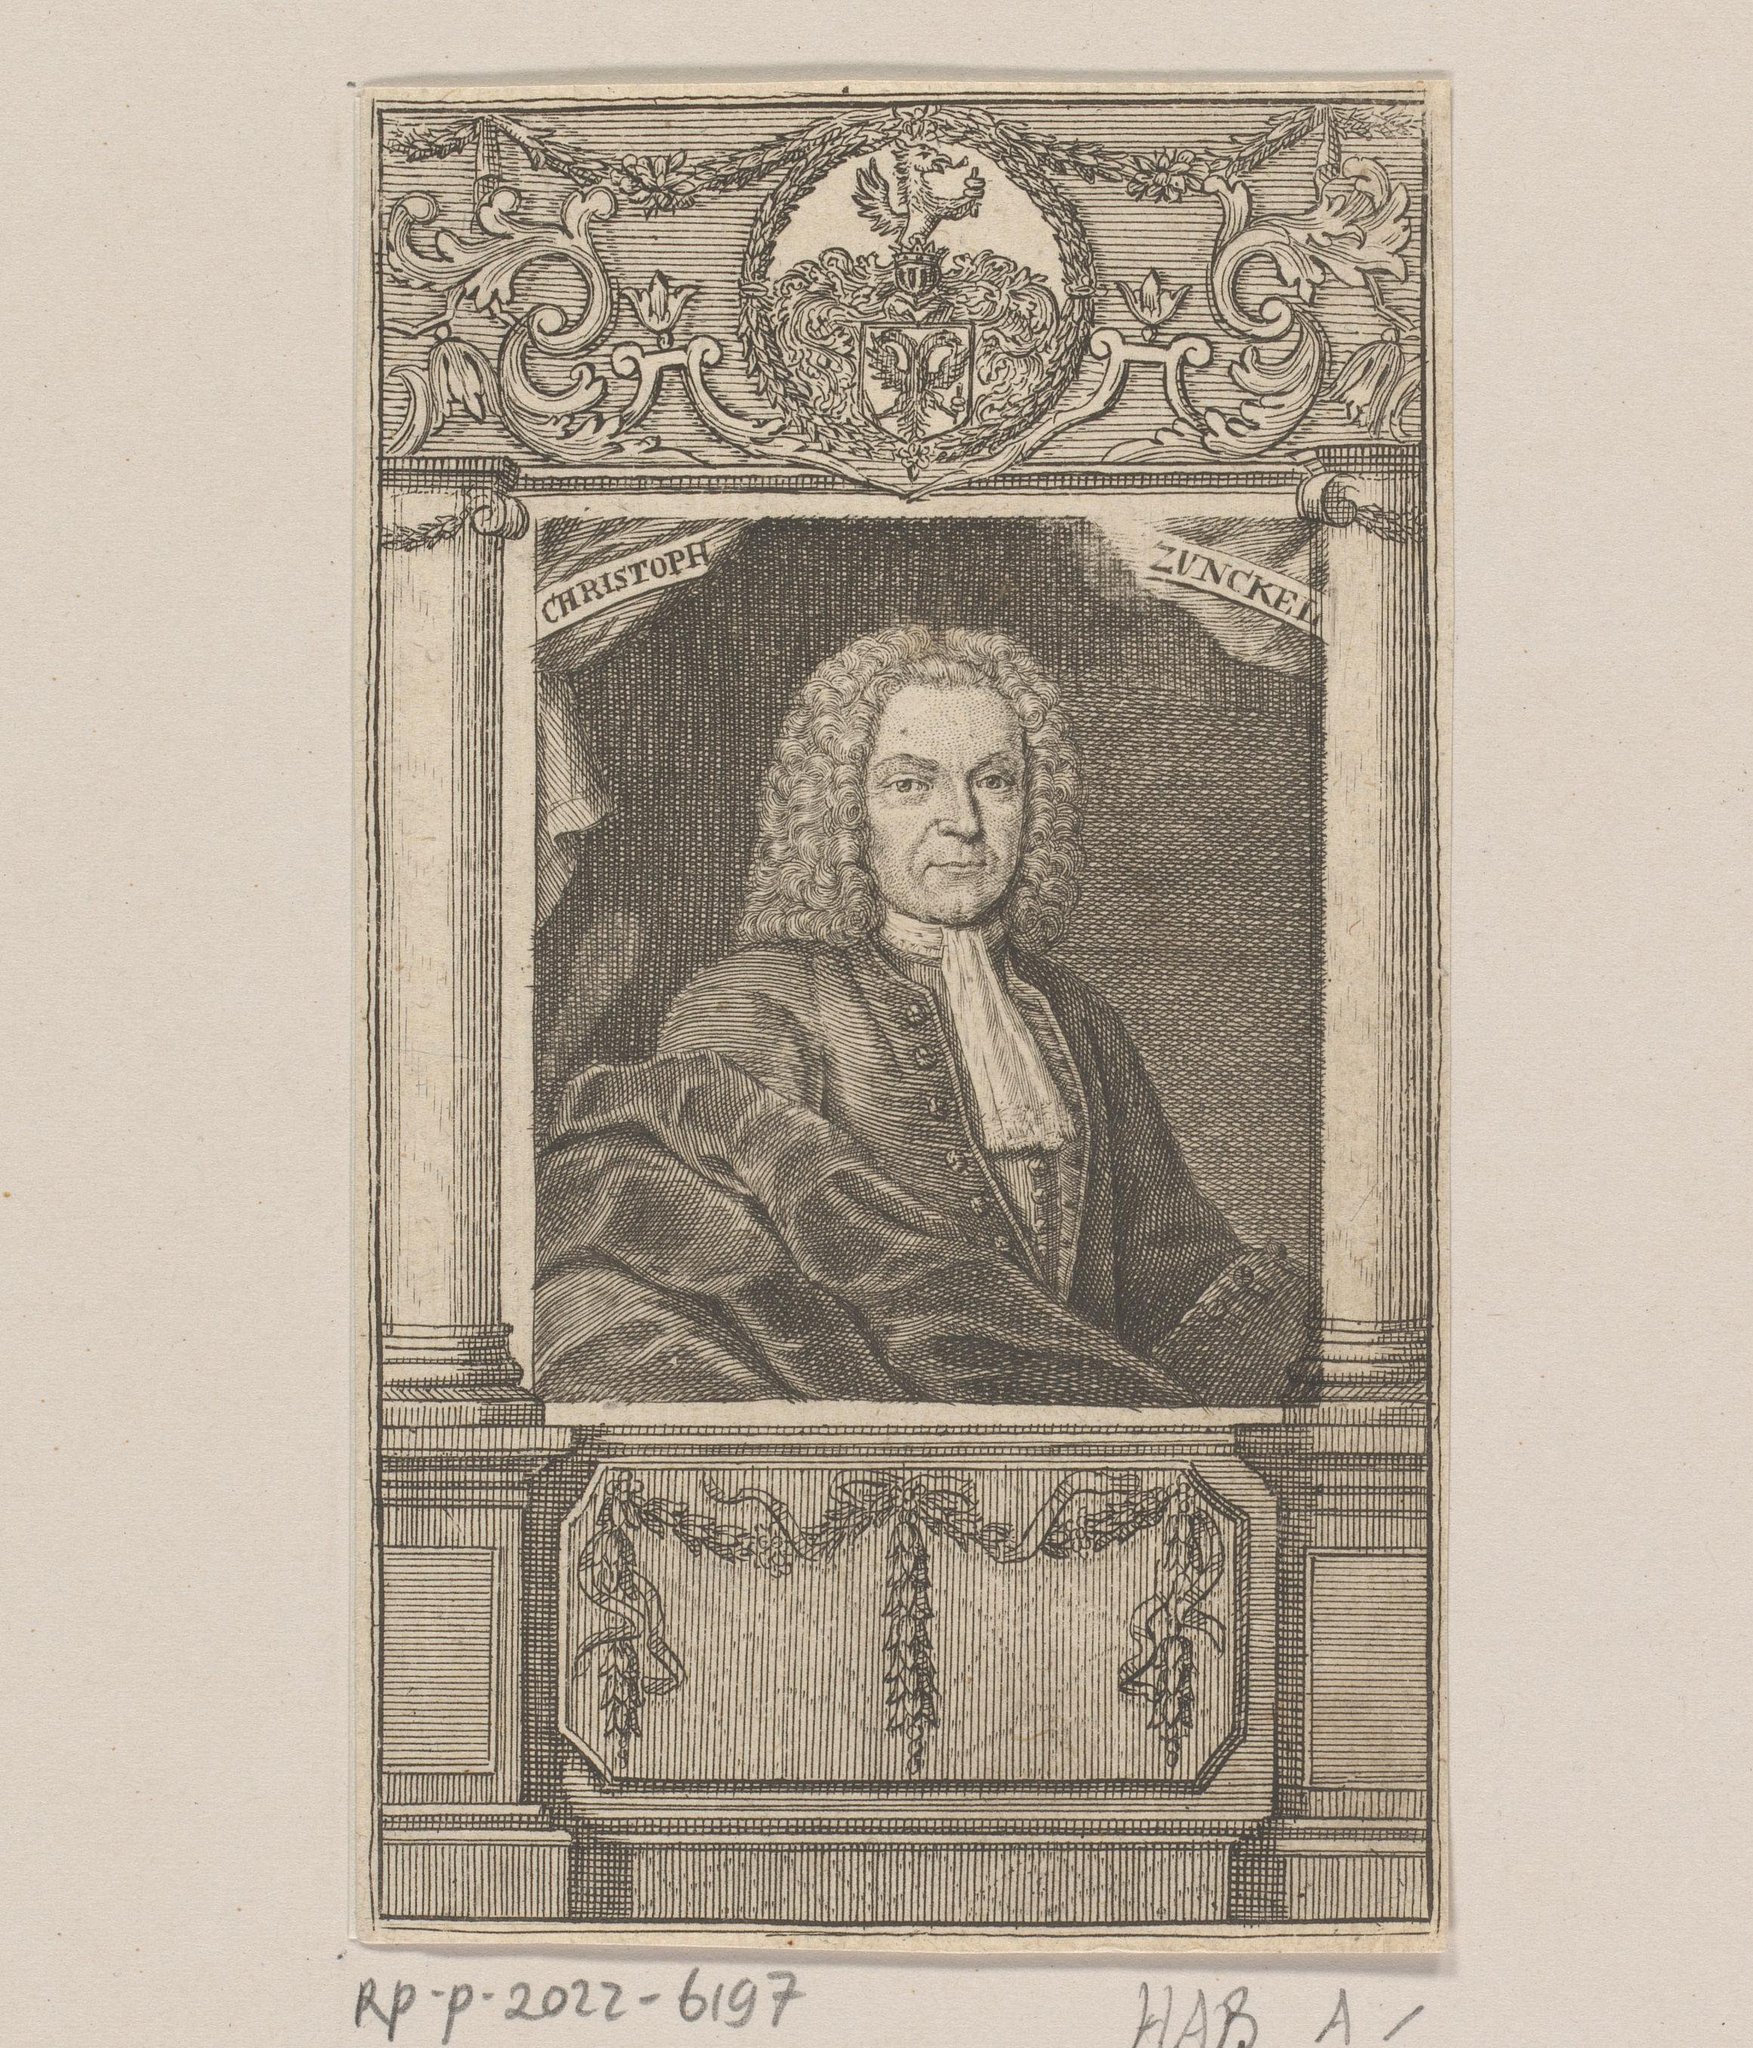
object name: book illustration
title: Portret van Christoph Zunckel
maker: Anonymous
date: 1740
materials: paper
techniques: etching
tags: christoph zunckel, historical persons, printer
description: Prent waarschijnlijk uit: Kappens, Johann Erhard. Die so nöthig als nützliche Buchdruckerkunst und Schriftgießerey: (...). Leipzig: Chirstian Friedrich Geßner, 1740, dl. 1.